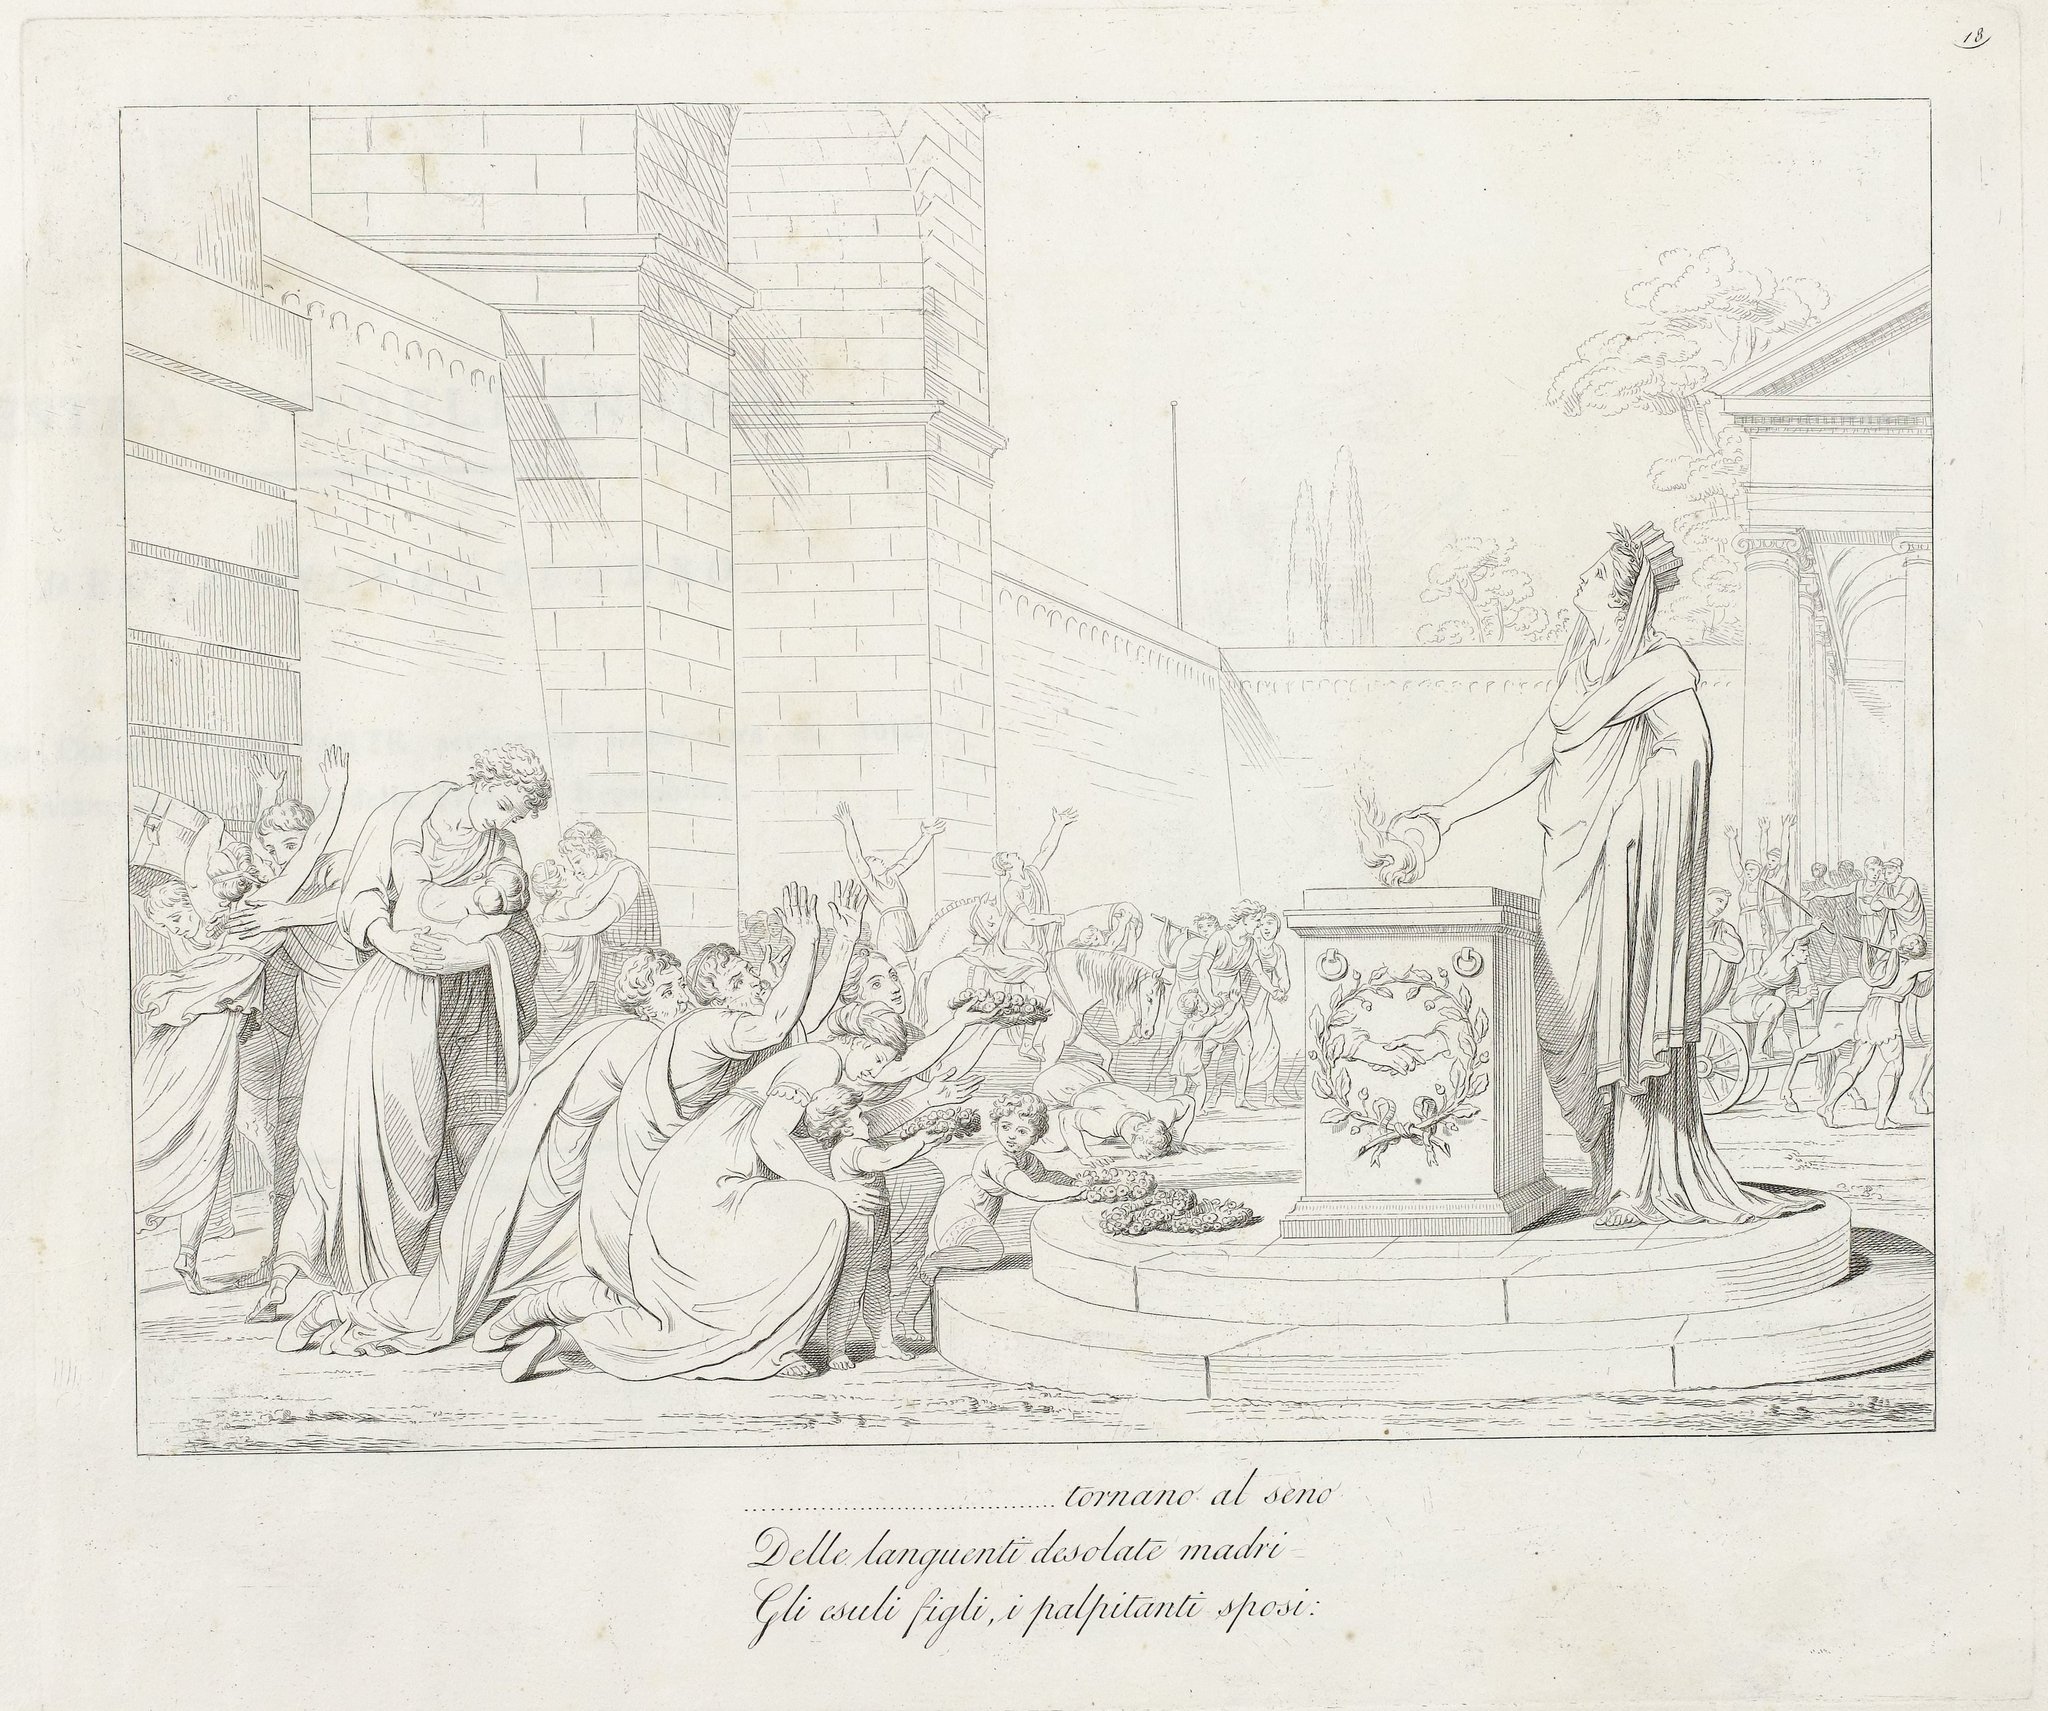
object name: album leaf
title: Illustraties bij het gedicht Pronea van Melchiore Cesarotti, een apologie voor Napoleon Bonaparte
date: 1808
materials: paper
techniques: etching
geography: milan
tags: napoleon i (emperor of the french), (public) prayer, altar ~ non-christian religions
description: Onder de voorstelling een versregel in het Italiaans. Prent maakt deel uit van een album.